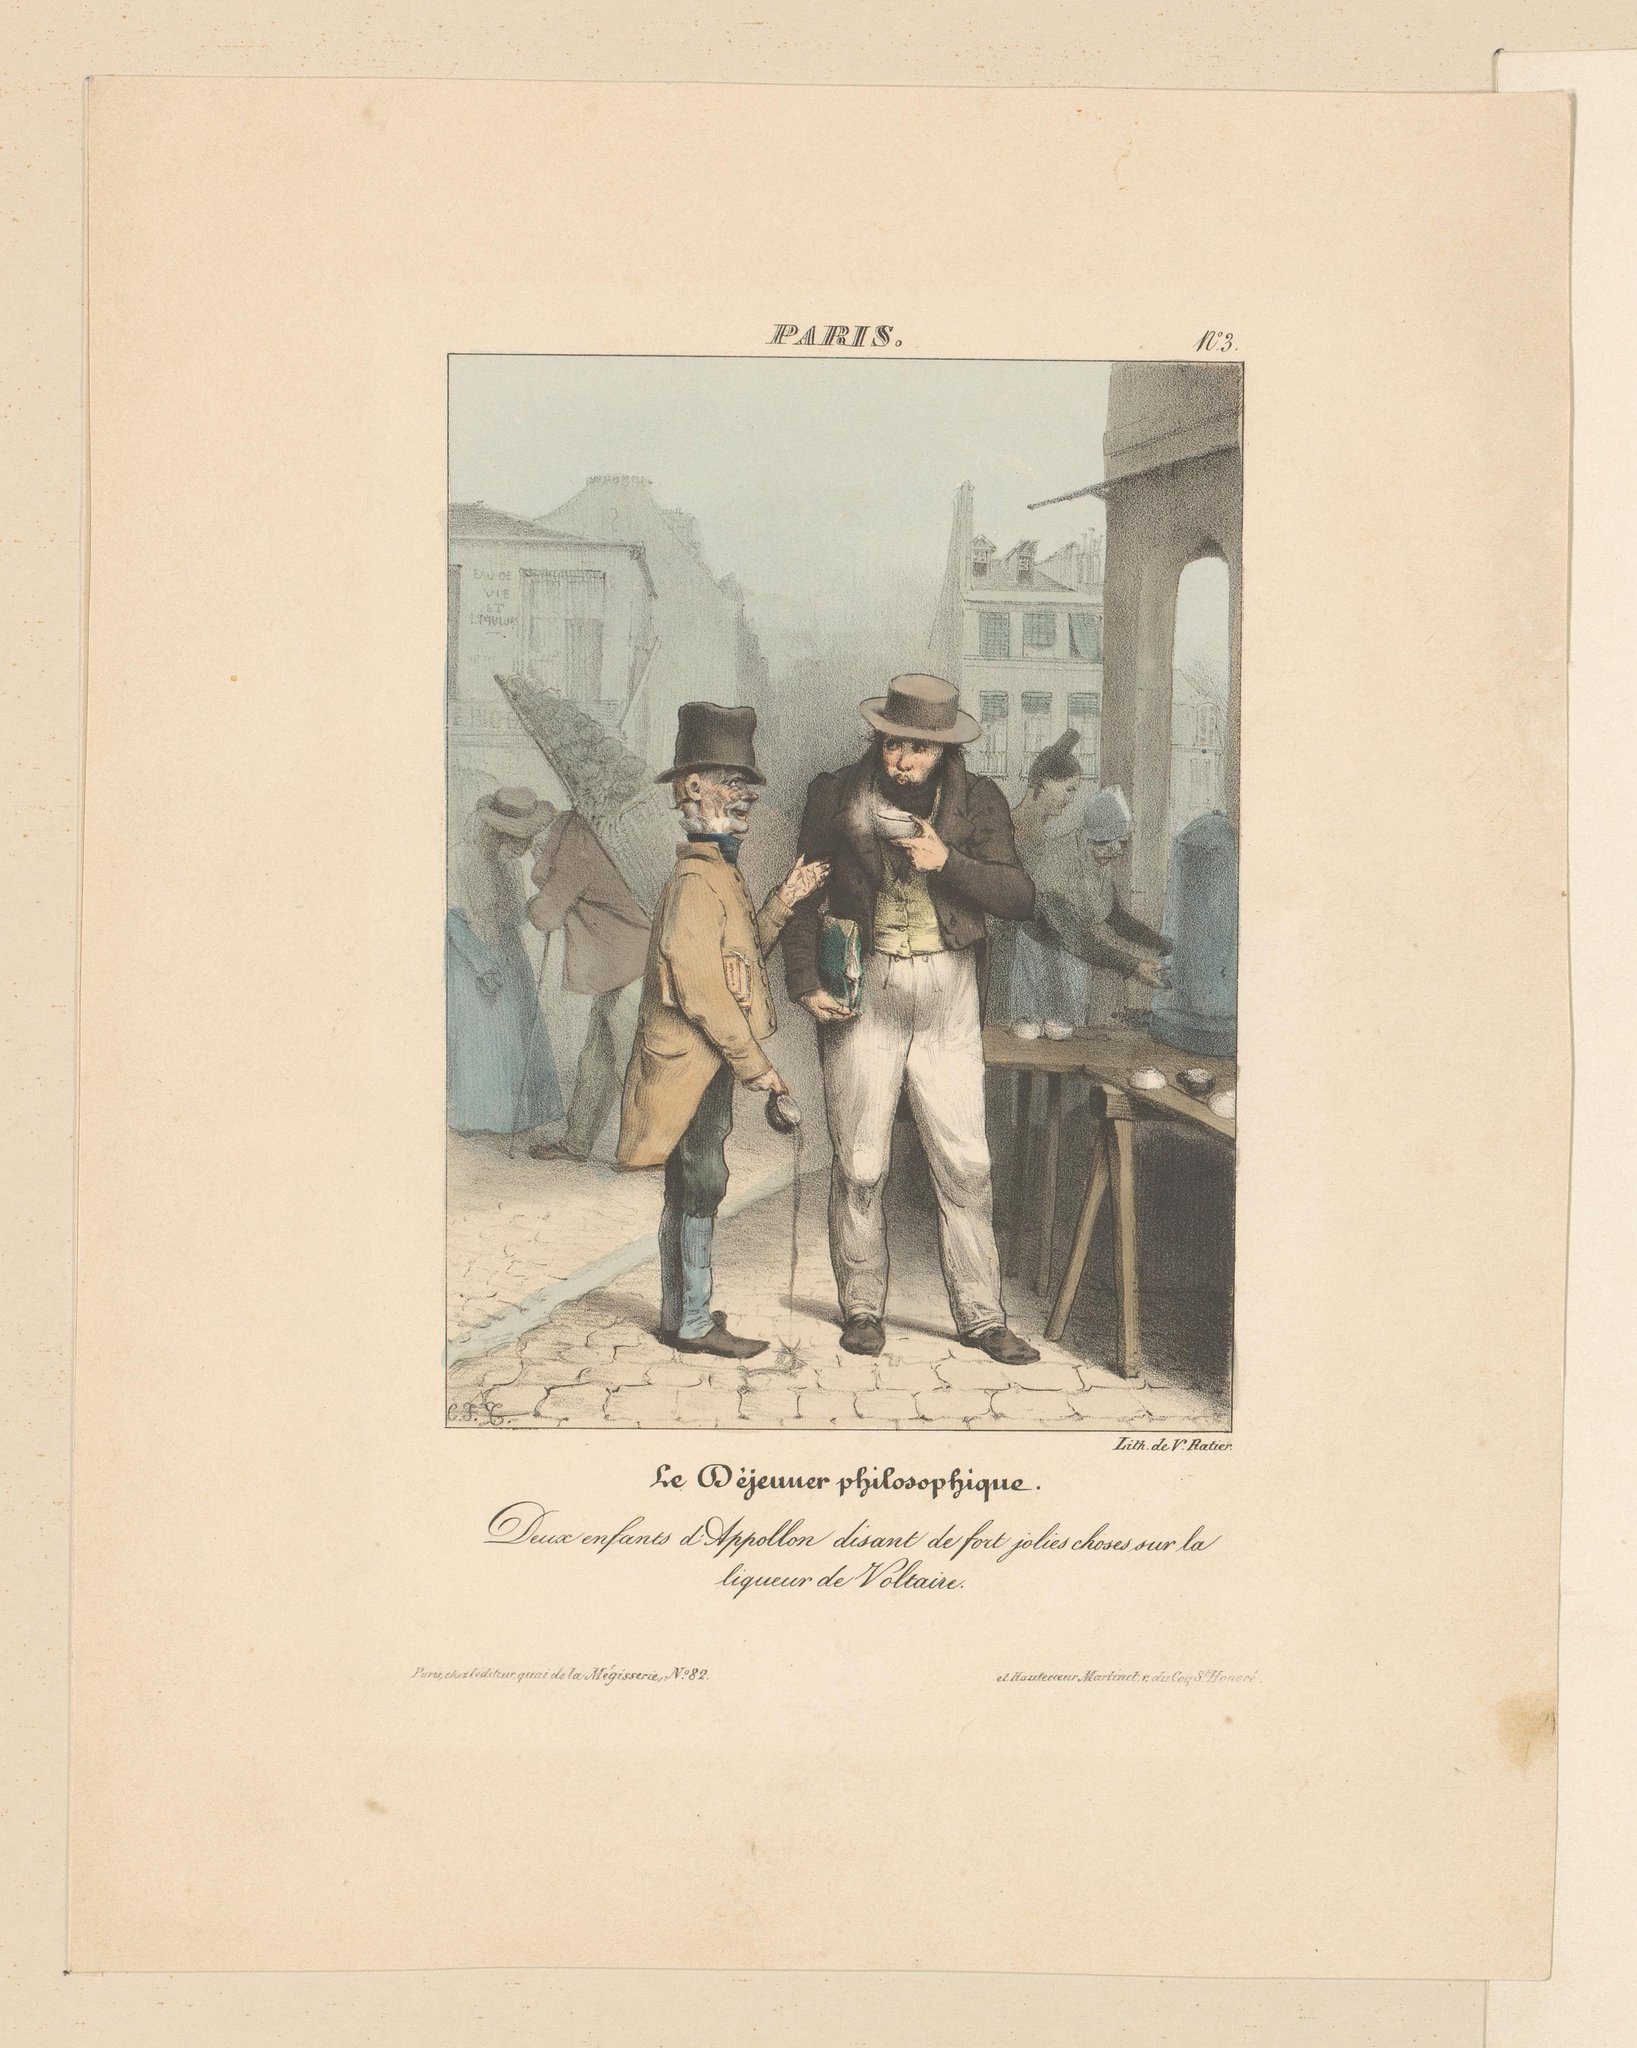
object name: print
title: Paris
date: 1838-1840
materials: paper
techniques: hand coloring, lithograph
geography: paris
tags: inn, coffee-house, public house, etc.